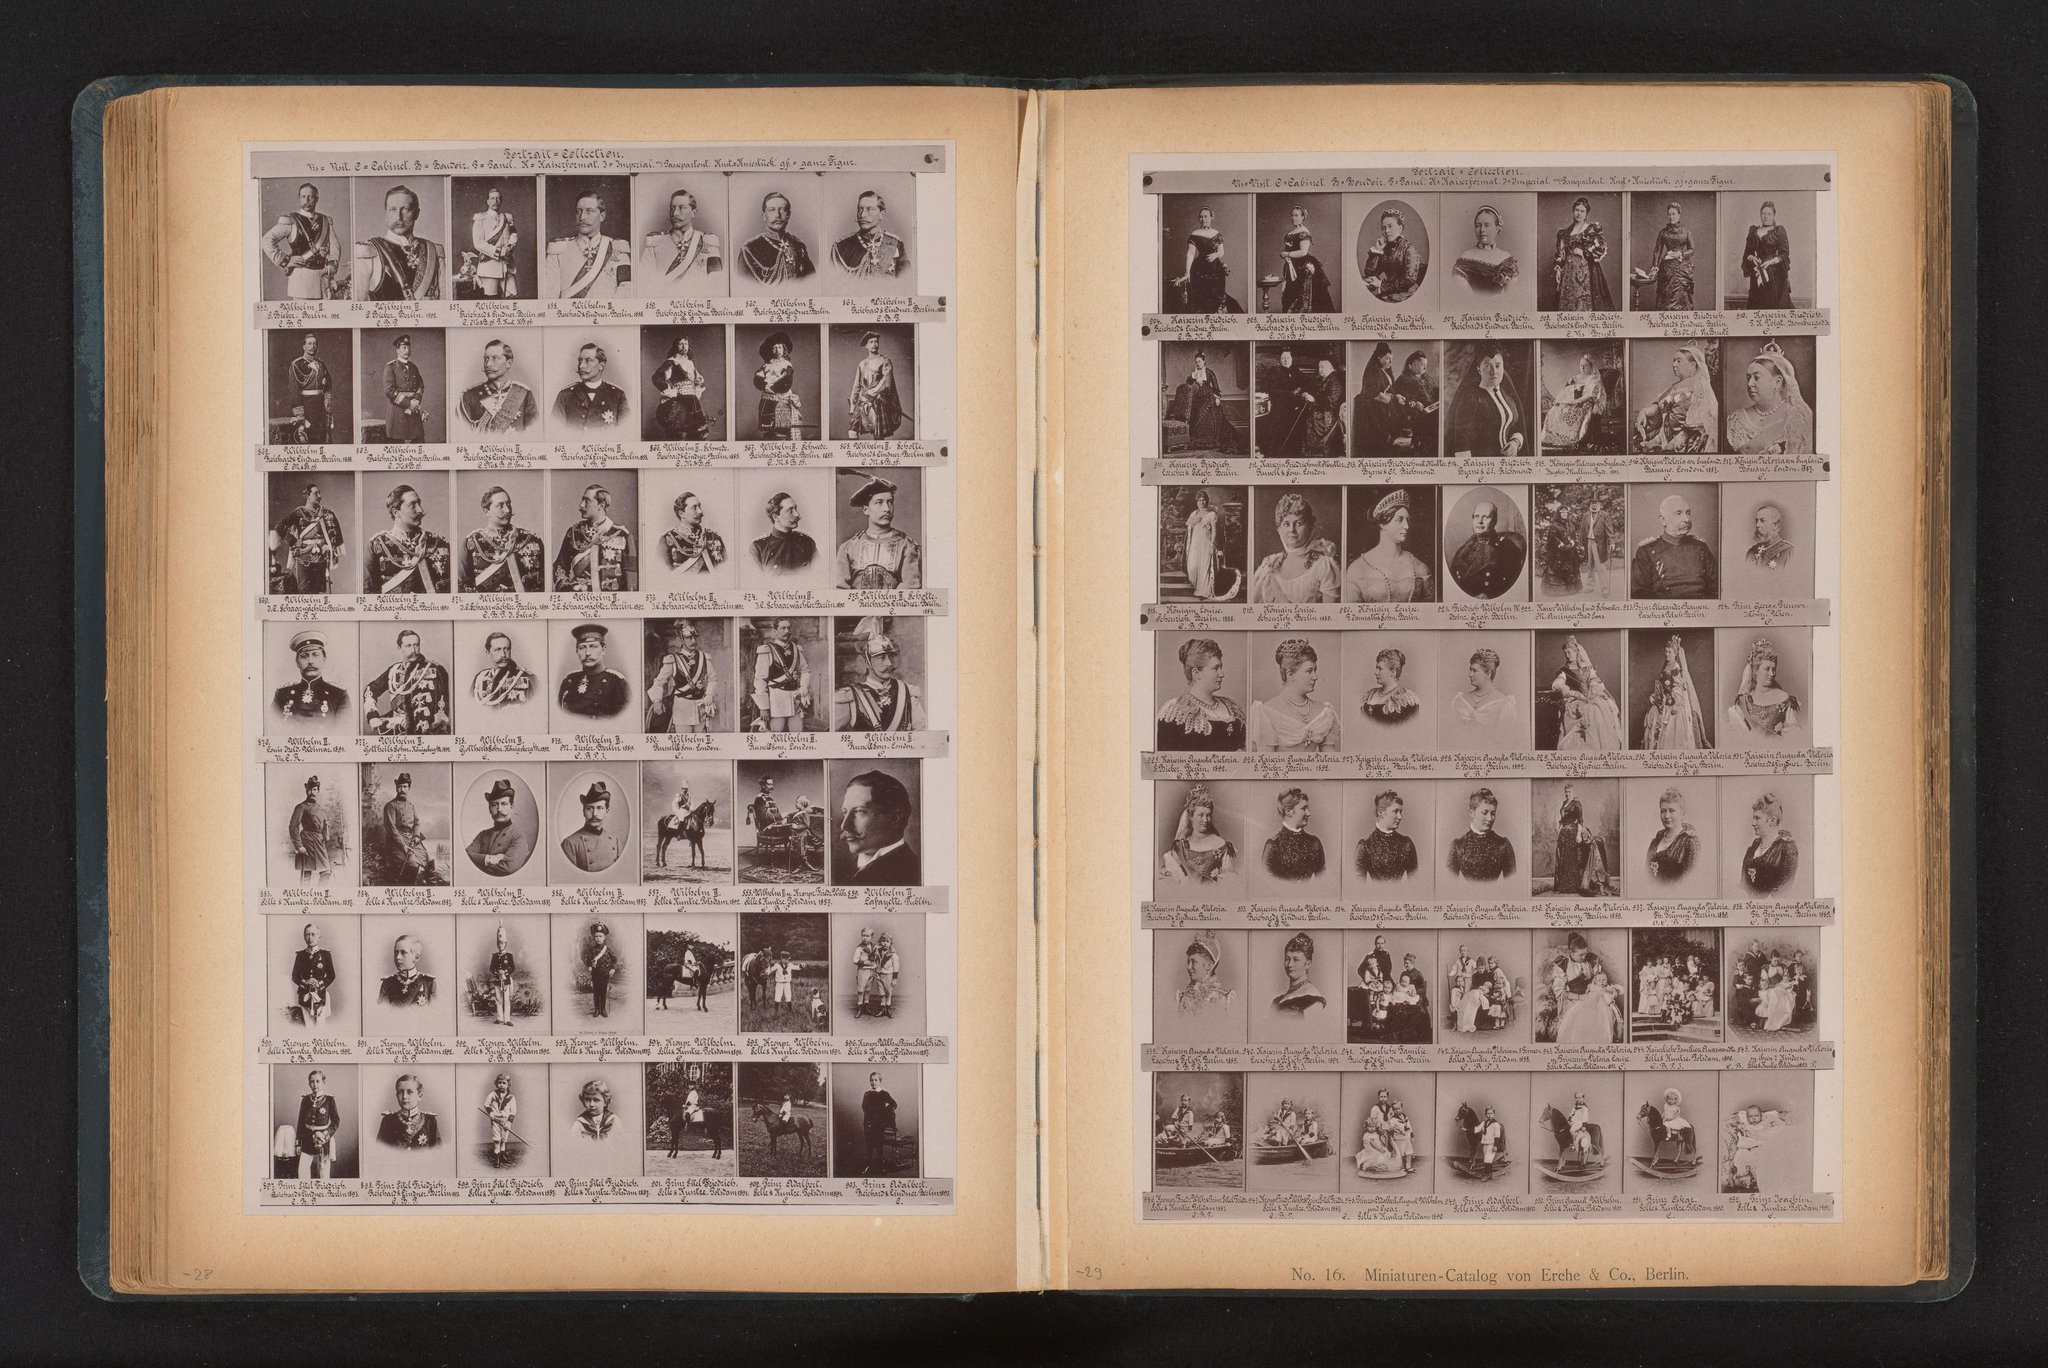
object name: photomechanical print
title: Portretten van Wilhelm II en zijn kinderen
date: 1880-1885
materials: paper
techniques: photograph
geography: berlin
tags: wilhelm ii (keizer van duitsland), emperor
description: Prent op achtentwintigste ongenummerde pagina.